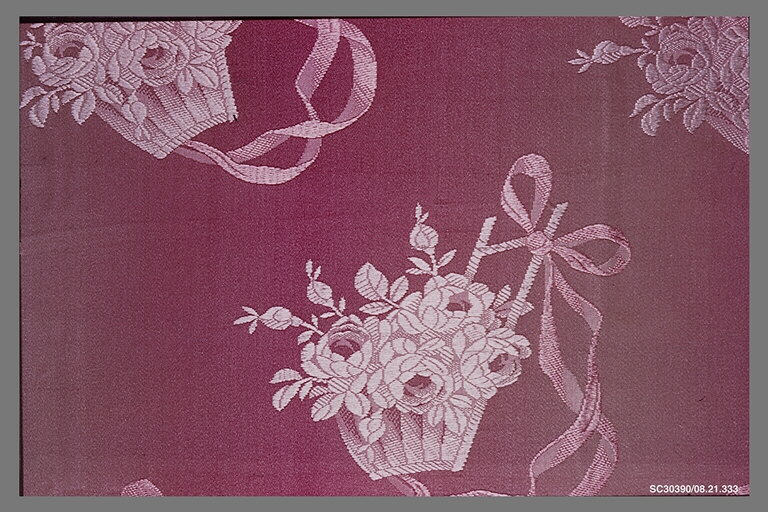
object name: textile sample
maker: Anonymous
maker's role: designer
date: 1900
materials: silk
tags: flowers